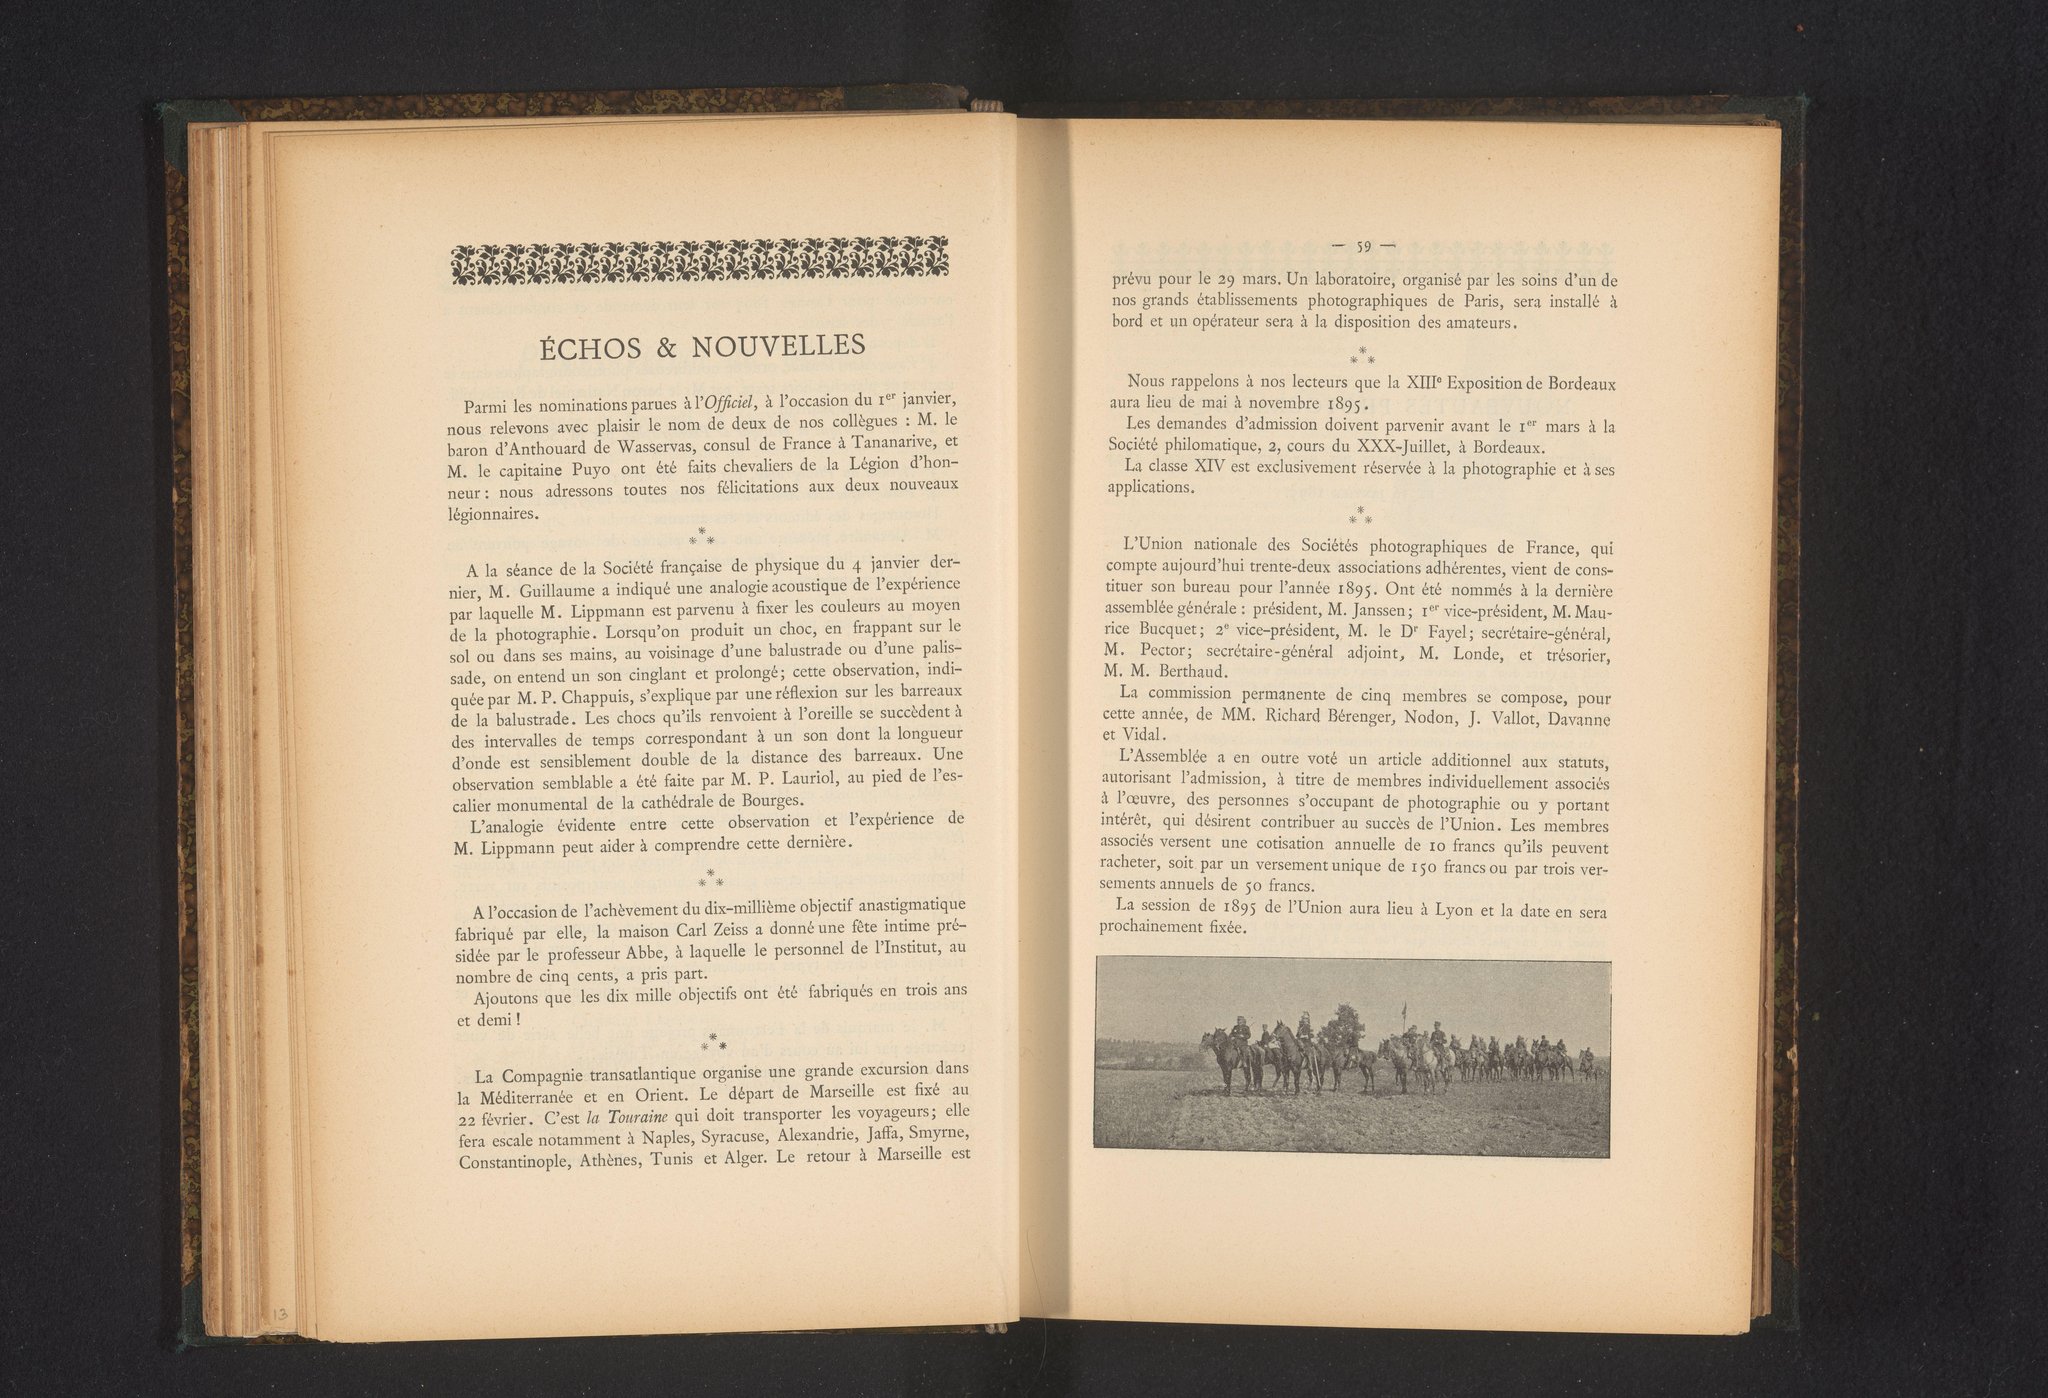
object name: photomechanical print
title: Groep mannen in uniform te paard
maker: Anonymous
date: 1890-1895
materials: paper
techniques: autotype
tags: riding a horse, ass, or mule; rider, horseman, (military) uniforms